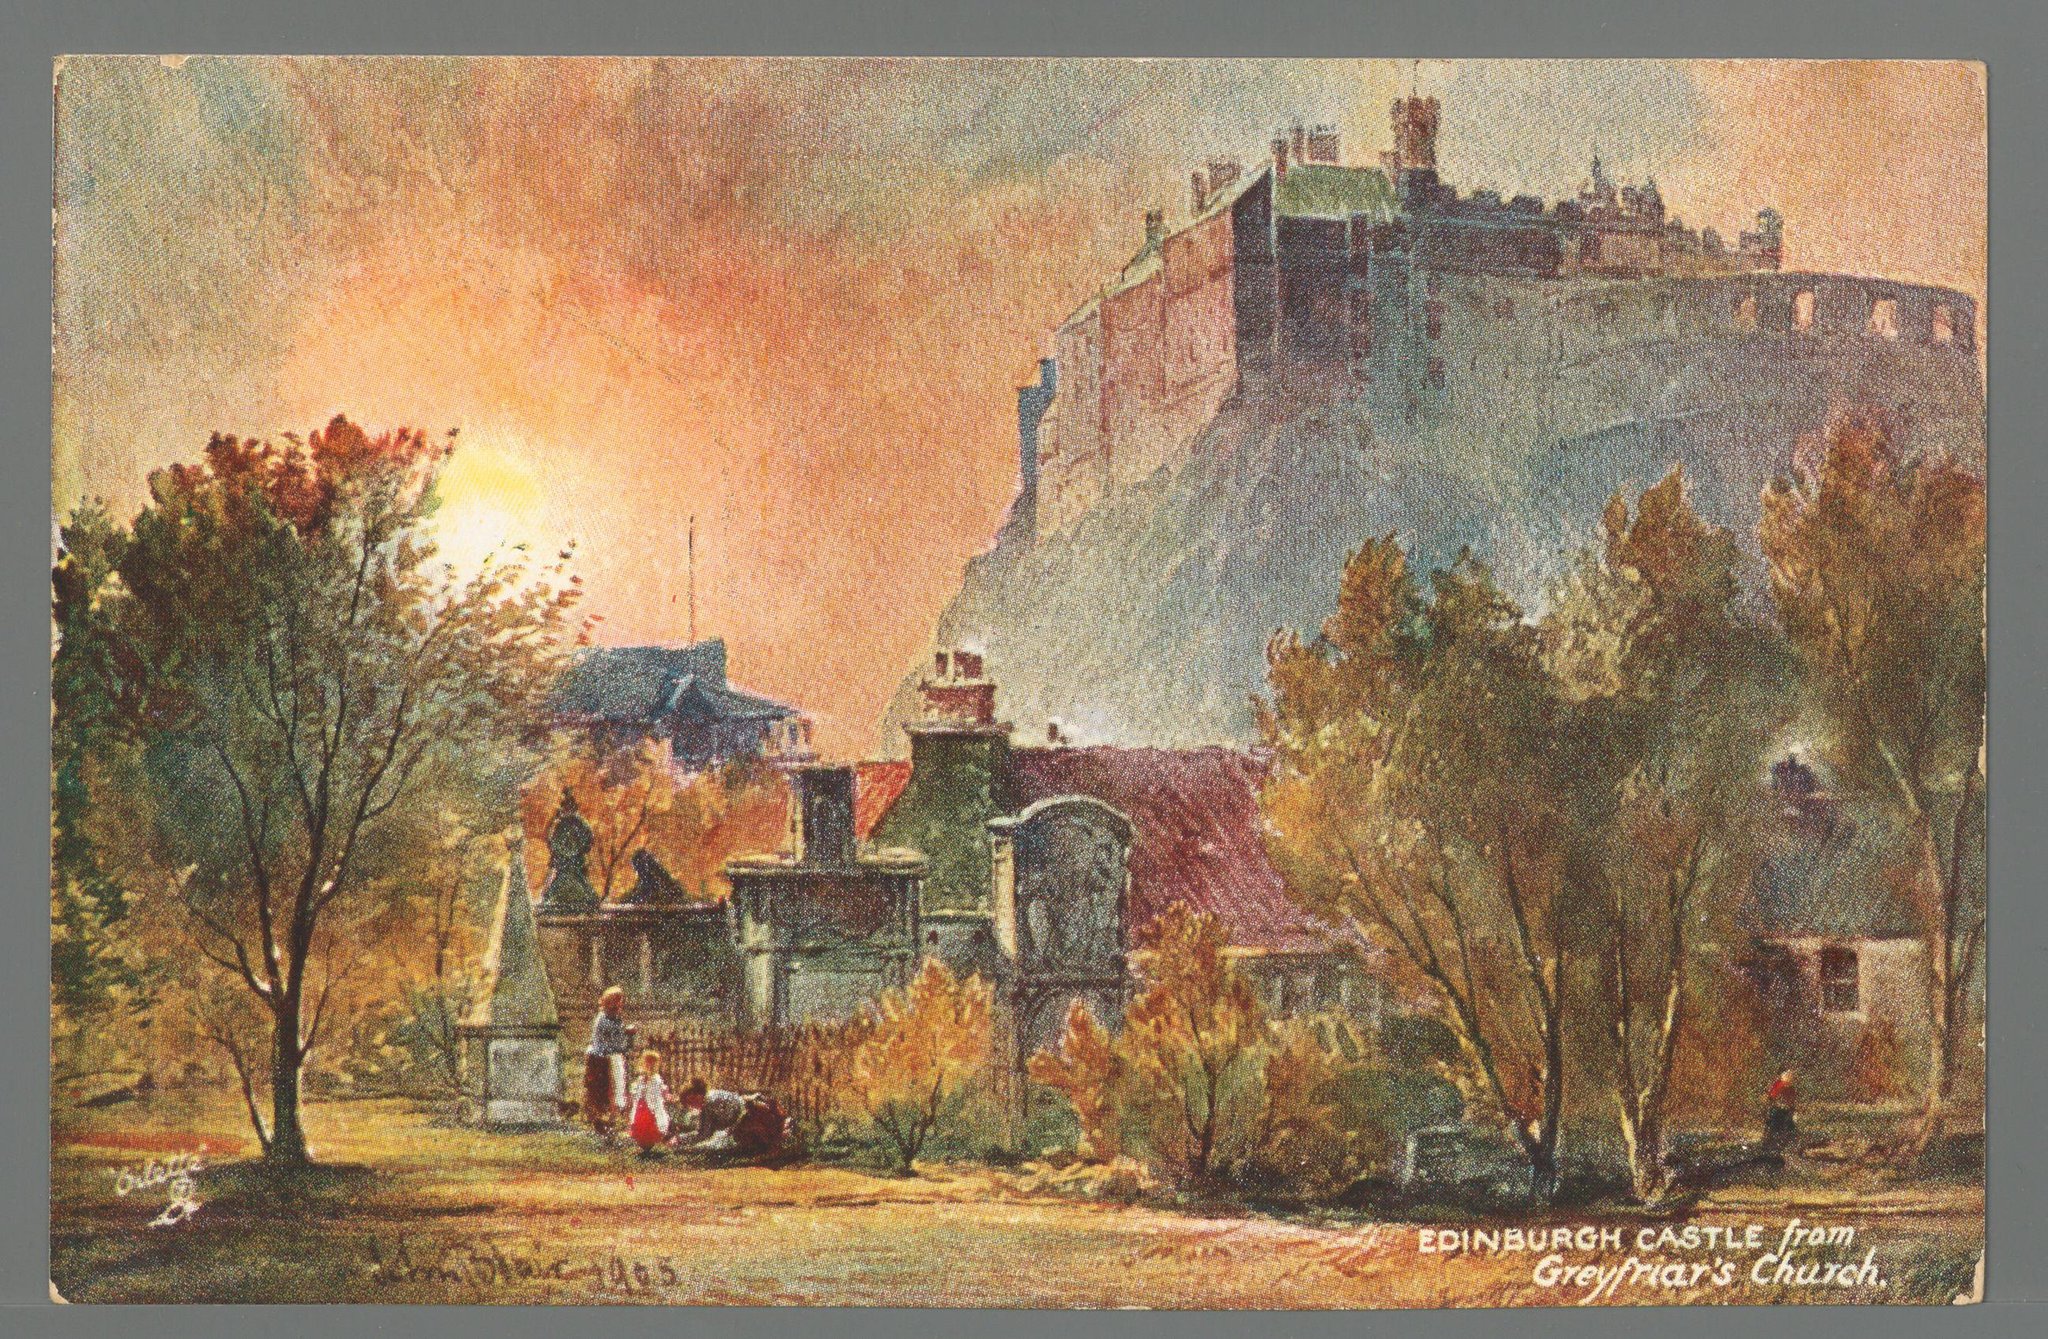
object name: ansichtkaart, prentbriefkaart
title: Edinburgh Castle from Greyfriar's Church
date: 1905-1912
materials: cardboard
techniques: color autotype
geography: london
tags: castle